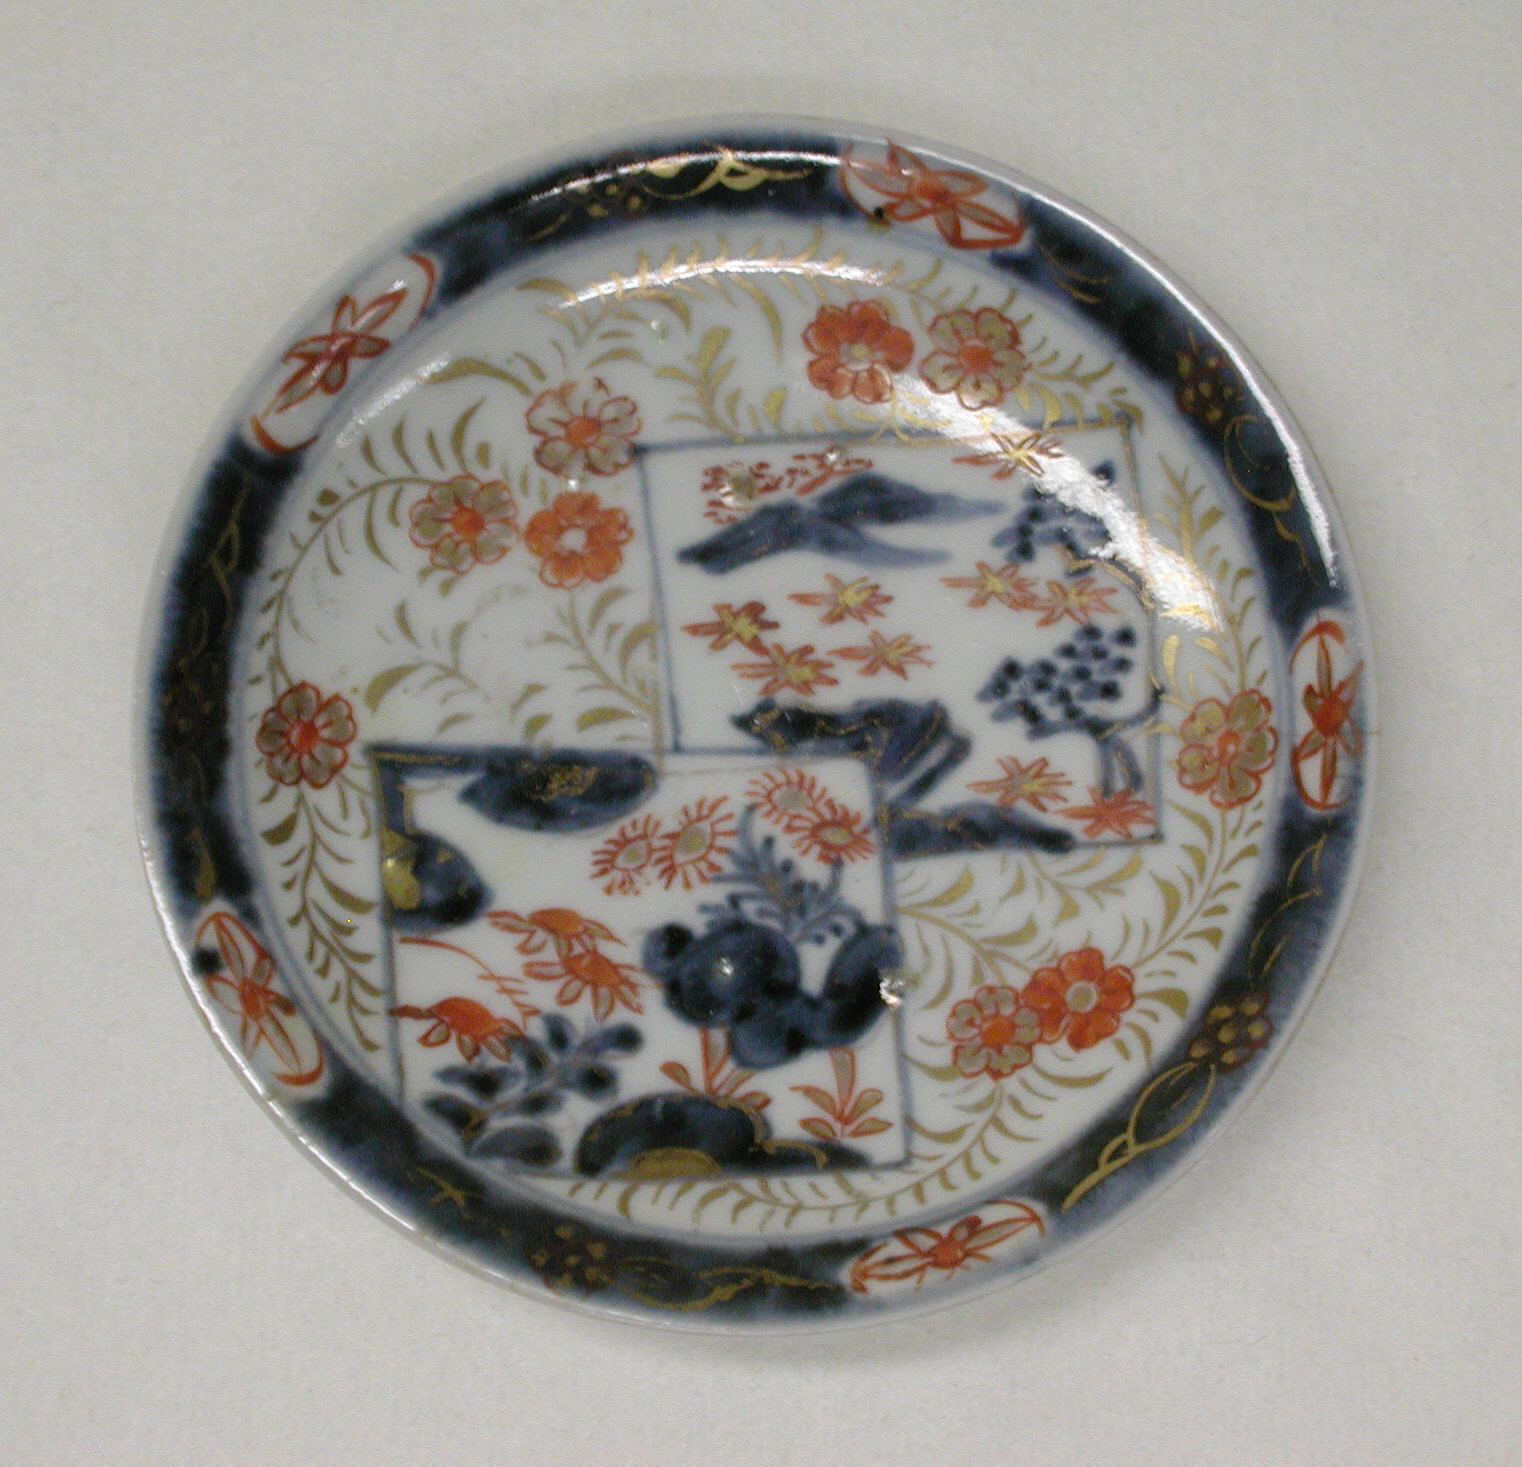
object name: saucer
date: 1701-1800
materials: porcelain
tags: flowers